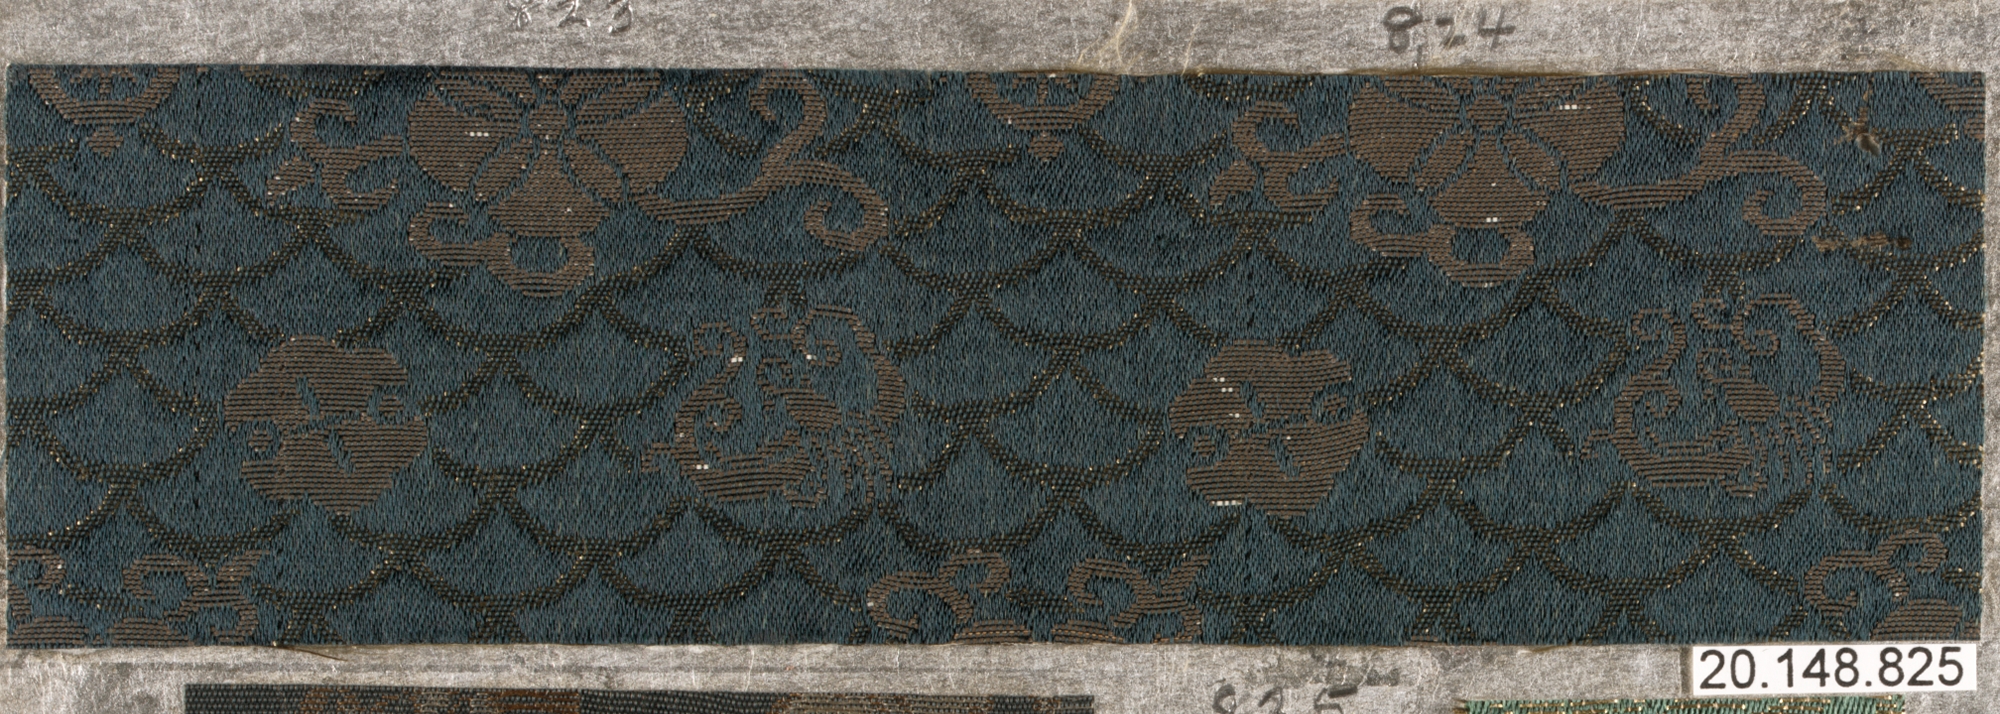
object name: piece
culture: japanese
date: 1701-1800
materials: silk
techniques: compound weave